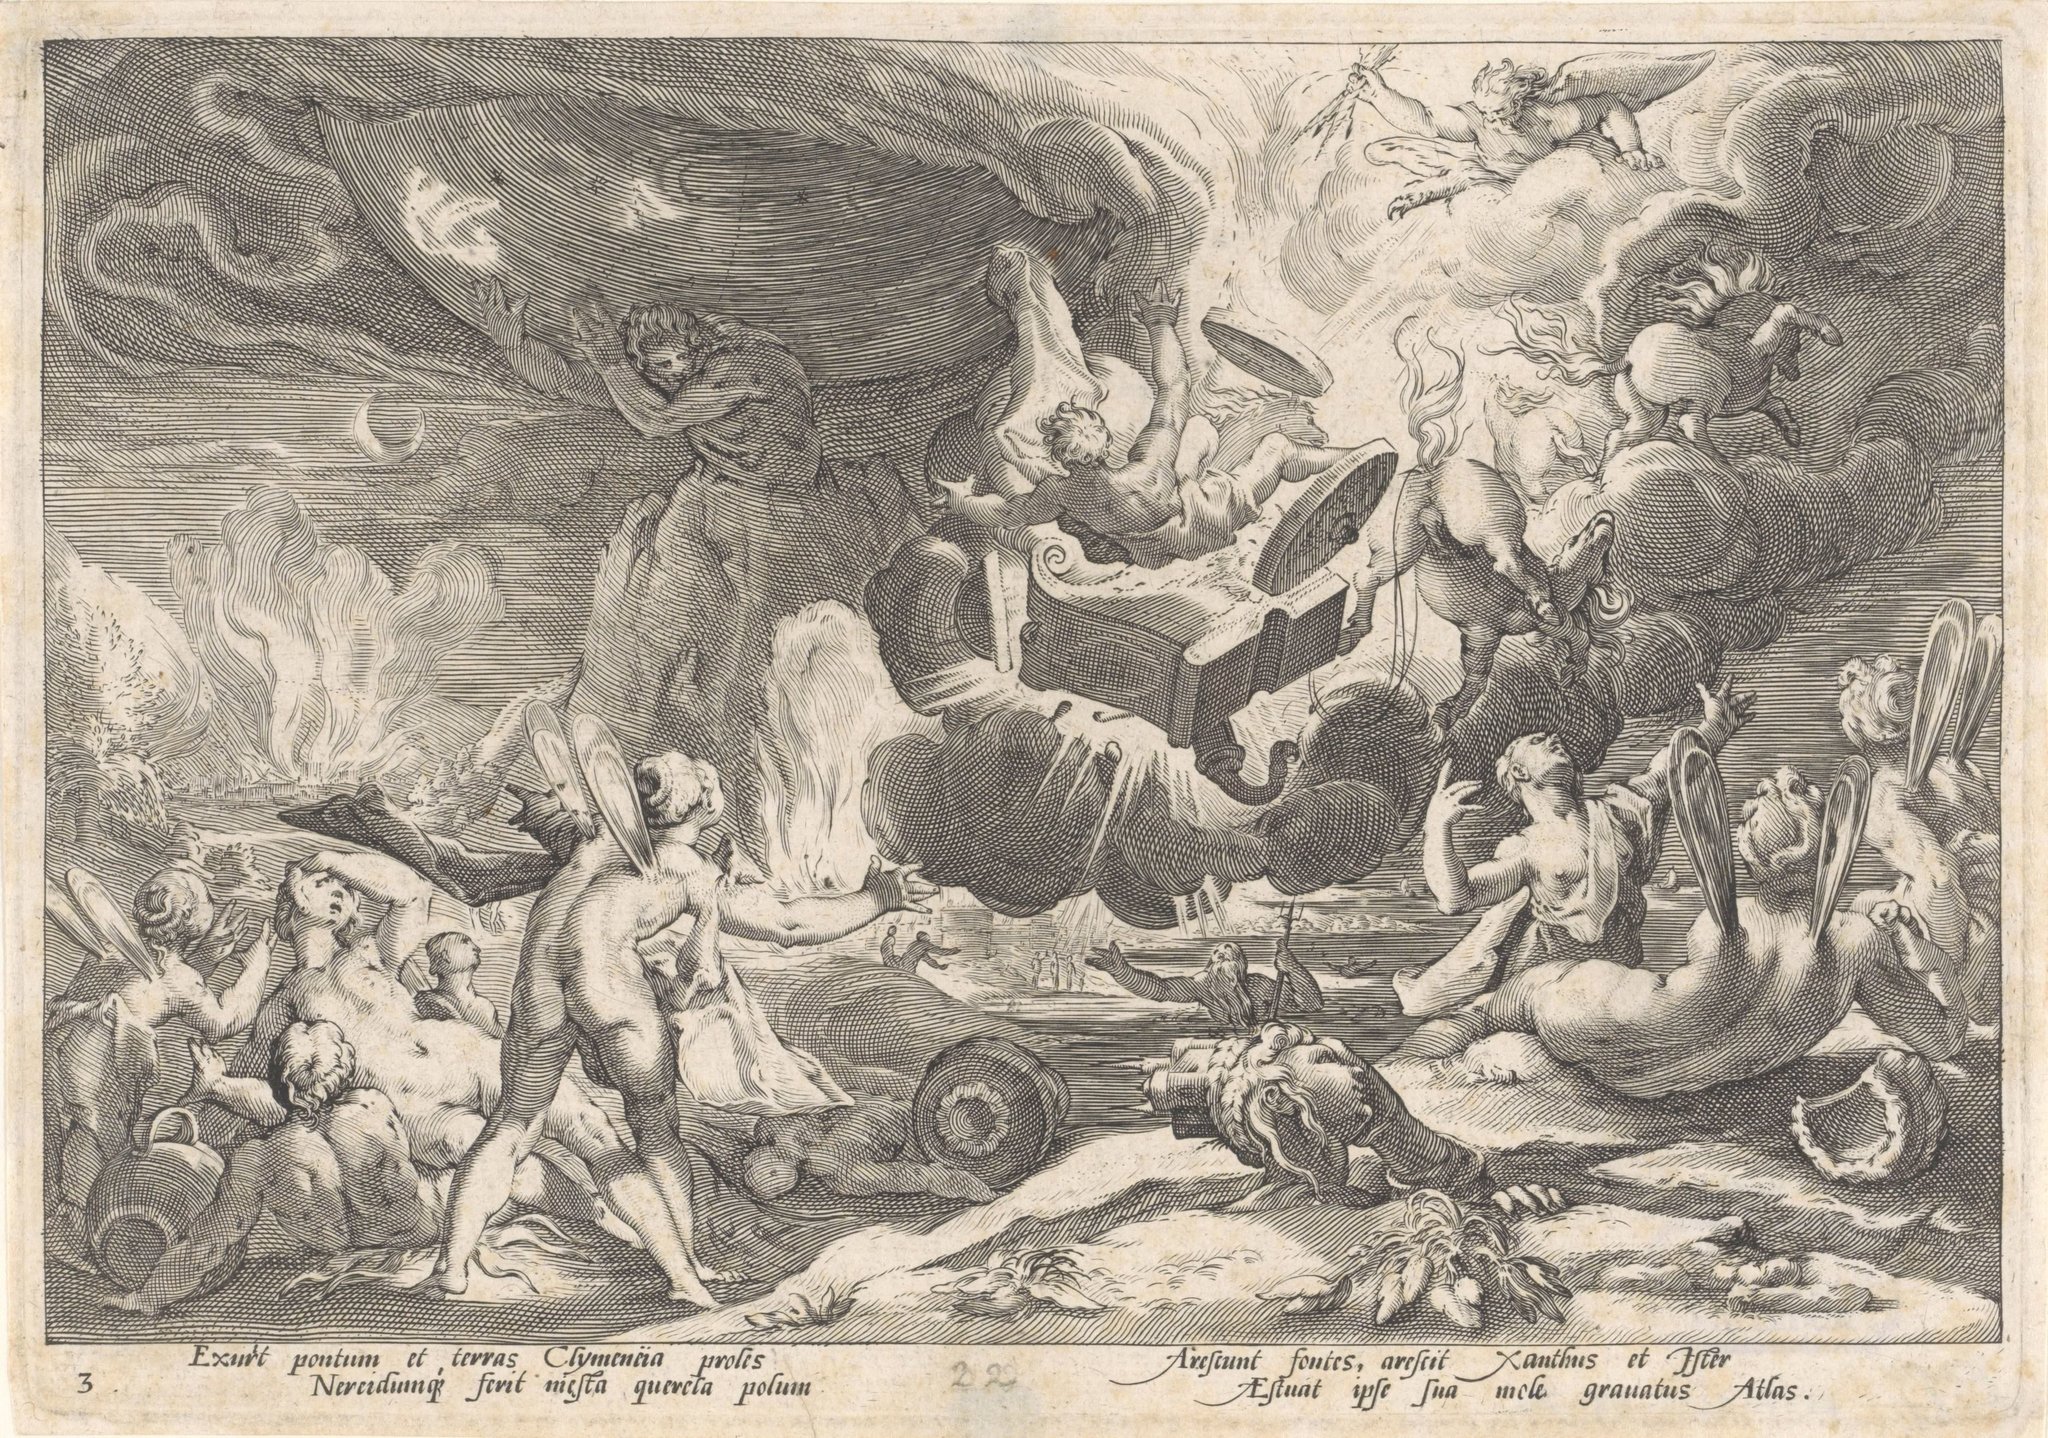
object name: print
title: Metamorfosen van Ovidius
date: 1590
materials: paper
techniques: engraving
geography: haarlem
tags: fall of phaethon; he is struck by a thunderbolt of jupiter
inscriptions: collector's mark: Lugt 11, collector's mark: ‘Hinloopen’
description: De rit van Phaëthon in de zonnewagen van zijn vader Apollo is uit de hand gelopen: de paarden zijn op hol geslagen en hebben de aarde in brand gezet. Jupiter gooit bliksemschichten en Phaëthon valt met wagen en al uit de hemel. In de ondermarge een vierregelige toelichting, in twee kolommen, in het Latijn.